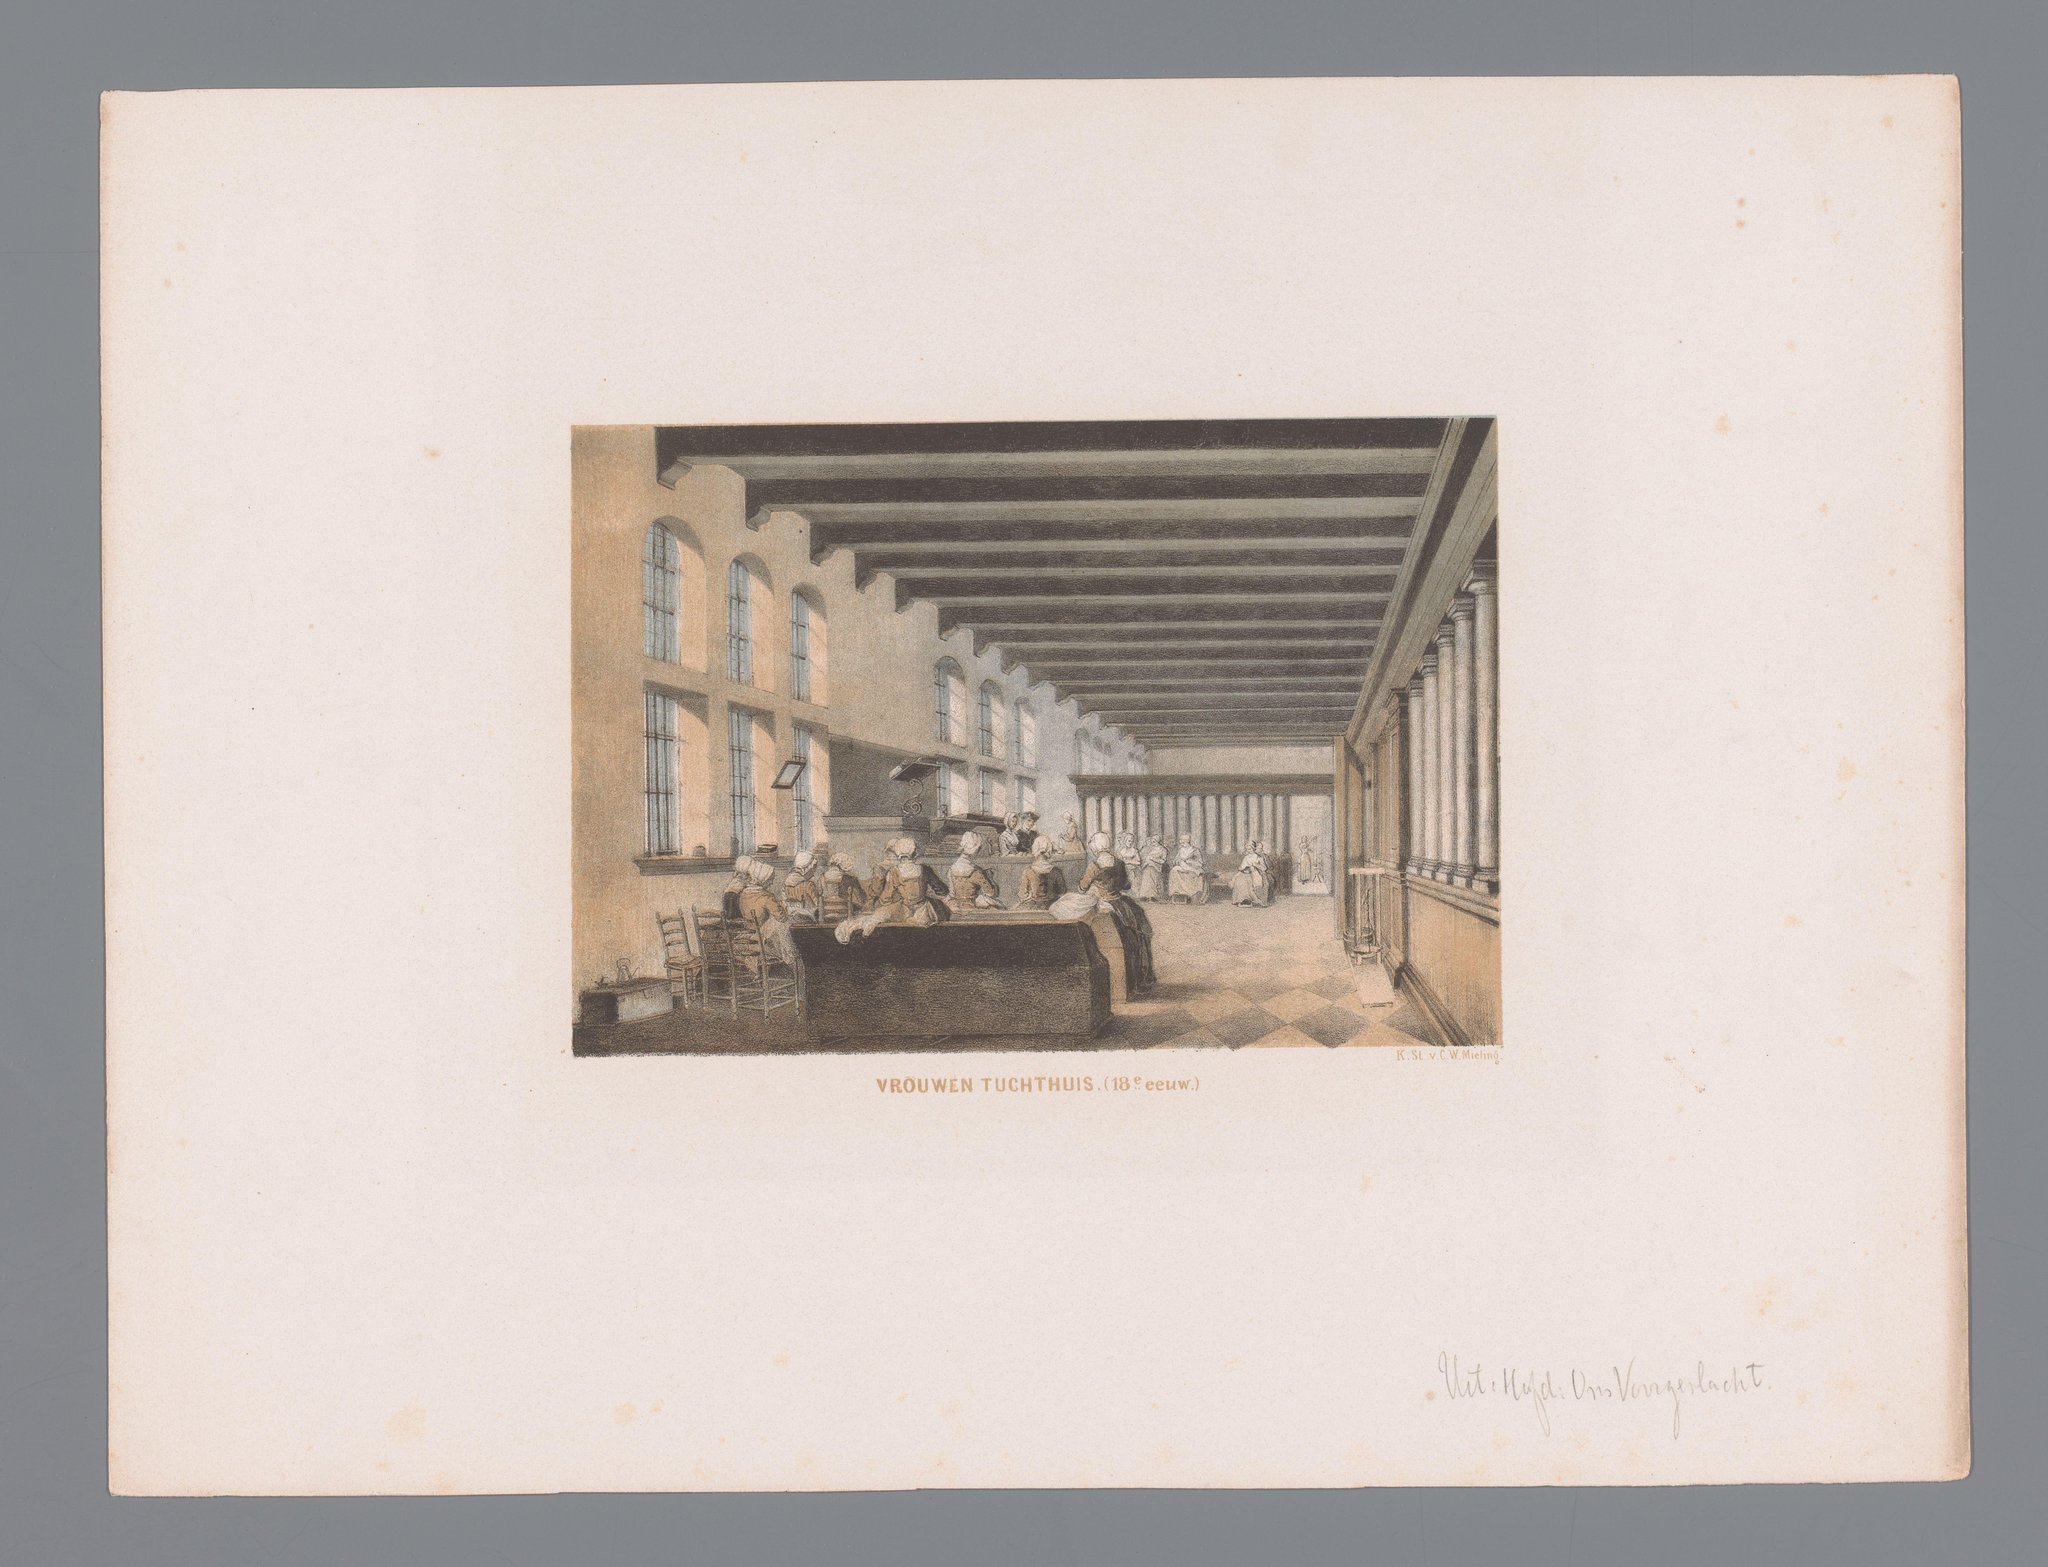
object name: print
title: Interieur van een tuchthuis voor vrouwen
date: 1864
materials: paper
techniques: tone lithography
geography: the hague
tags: prison, jail, specialized institutions, sewing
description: De vrouwen zitten op stoelen en banken. Ze hebben een stuk stof in hun handen en zijn bezig met naaiwerk. In het midden staan twee toezichthouders.